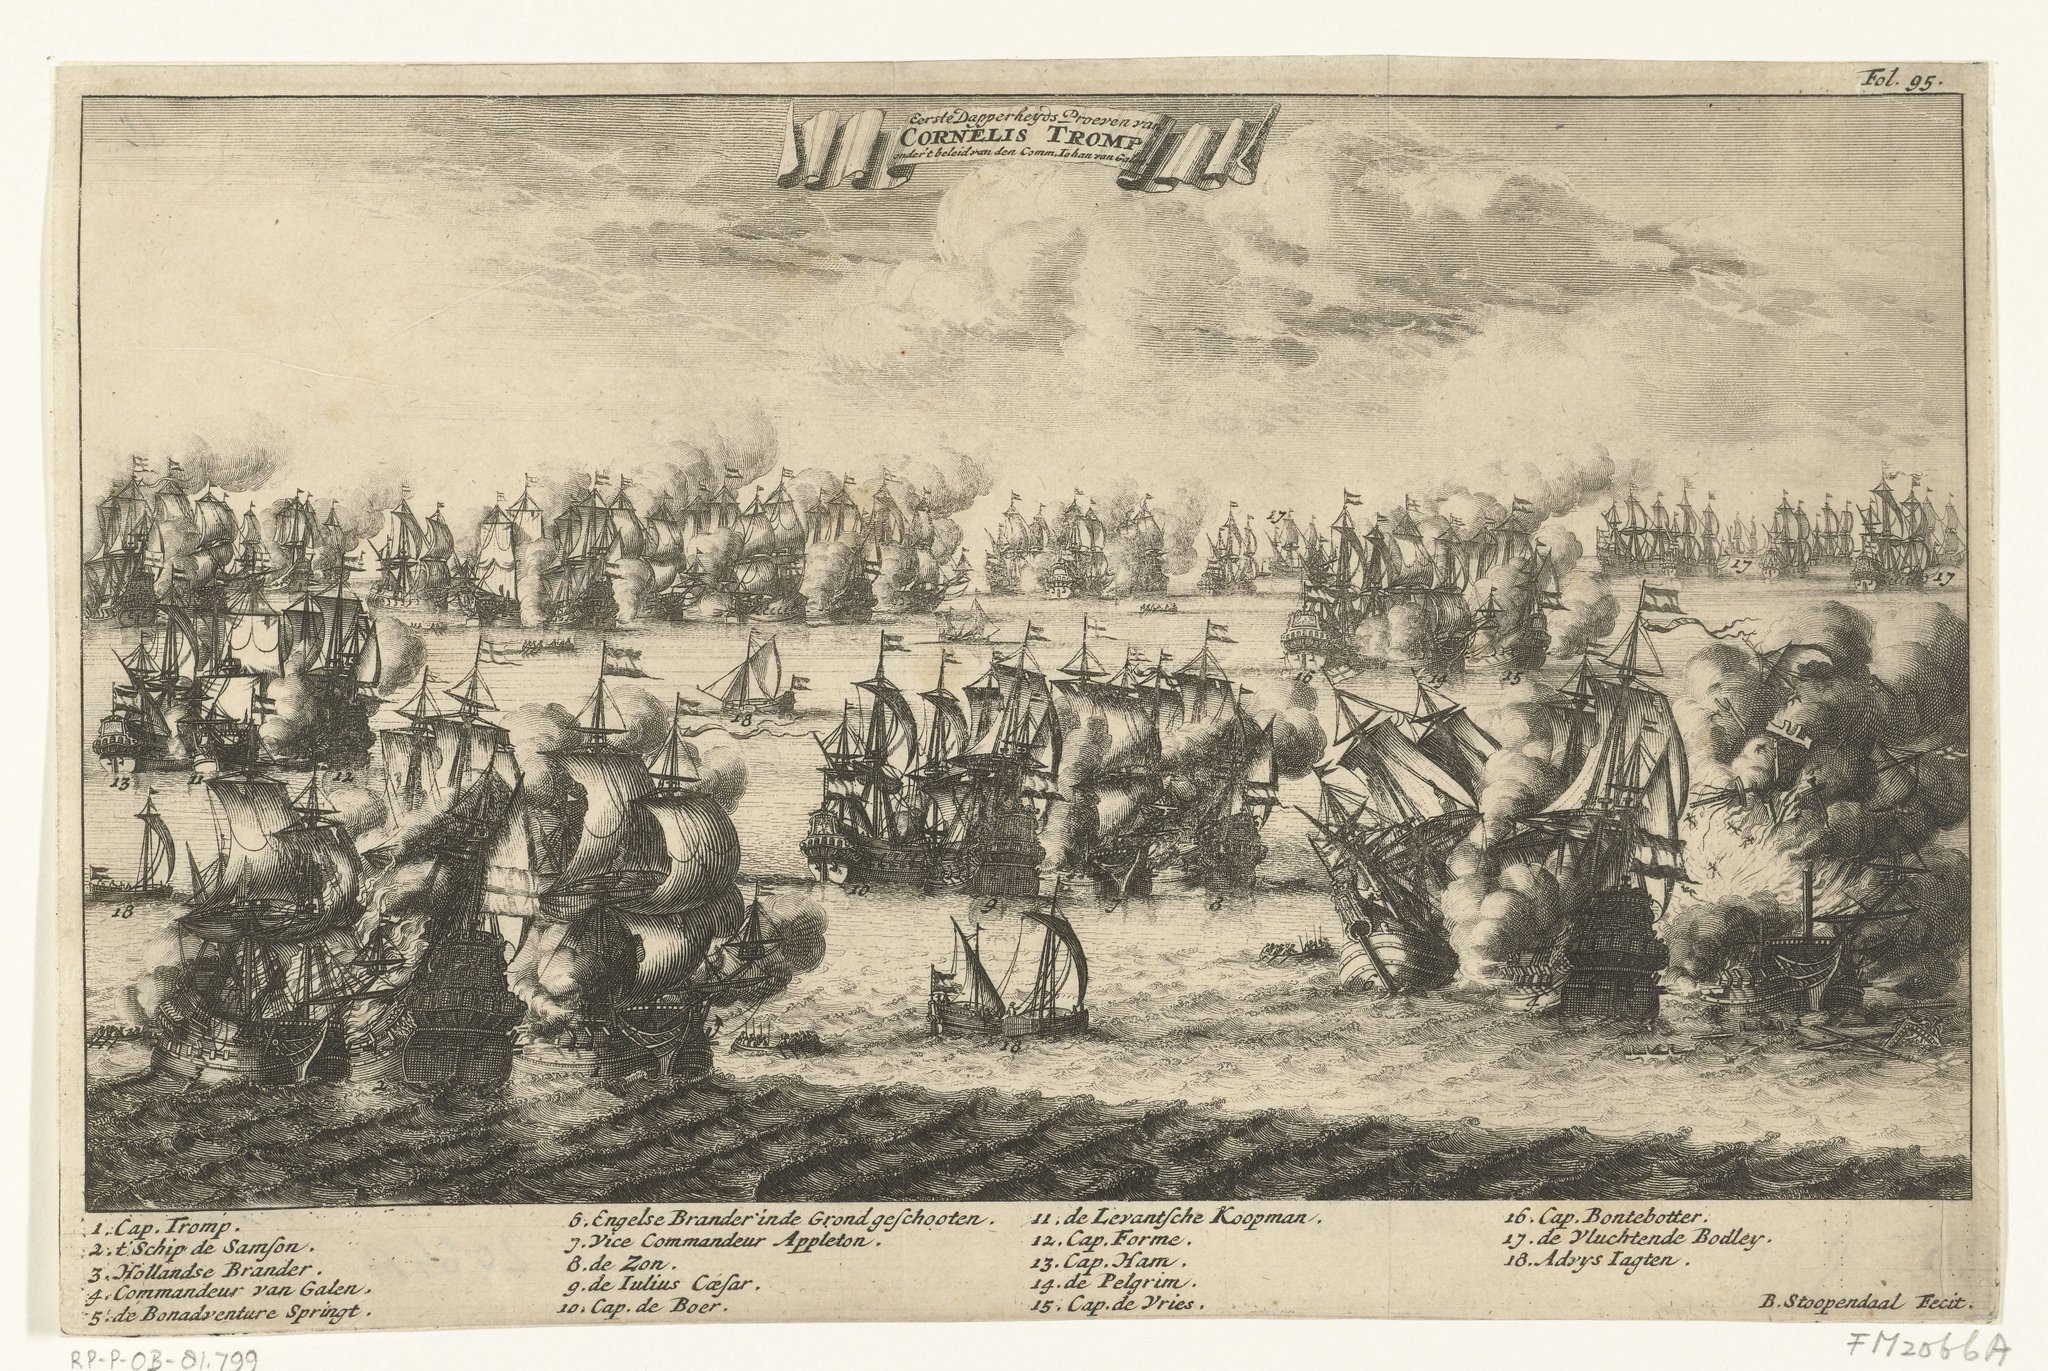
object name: history print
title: Eerste Dapperheyds Proeven van Cornelis Tromp onder 't beleid van den Comm. Johan van Galen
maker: bastiaen stopendael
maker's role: print maker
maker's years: 1636-1693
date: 1690-1692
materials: paper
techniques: etching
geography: northern netherlands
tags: amsterdam, cornelis tromp, battle (+ naval force), battle of leghorn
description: De zeeslag bij Livorno tijdens de Eerste Engelse Oorlog tussen de Staatse vloot onder Johan van Galen en Cornelis Tromp en de Engelse vloot onder Henry Appleton en Richard Badiley, 14 maart 1653. In het onderschrift de legenda 1-18. Rechtsboven gemerkt: Fol. 95.